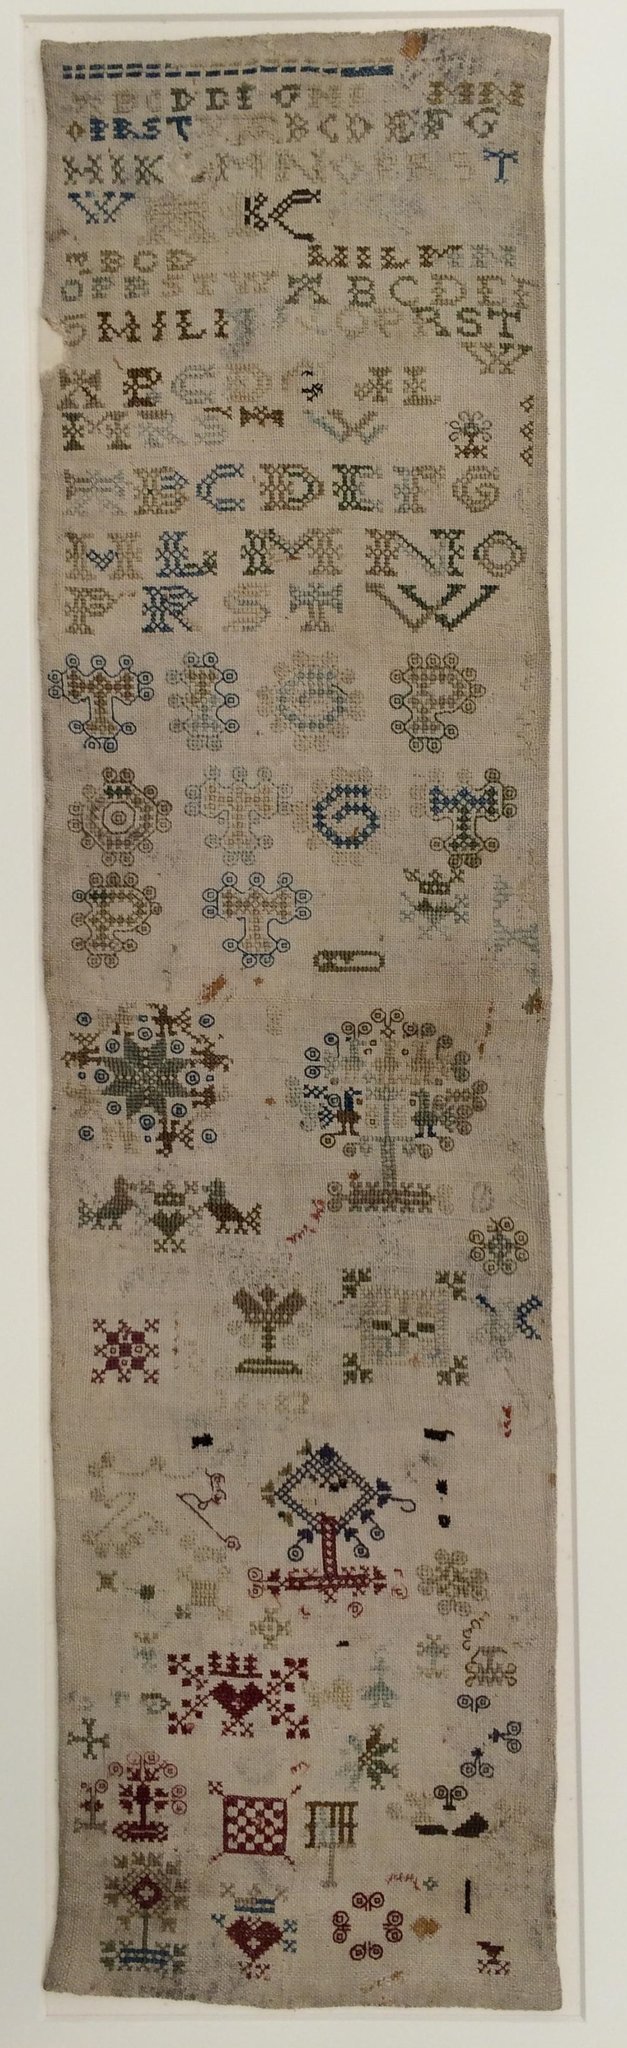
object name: sampler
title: Embroidered sampler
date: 1682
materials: linen, silk